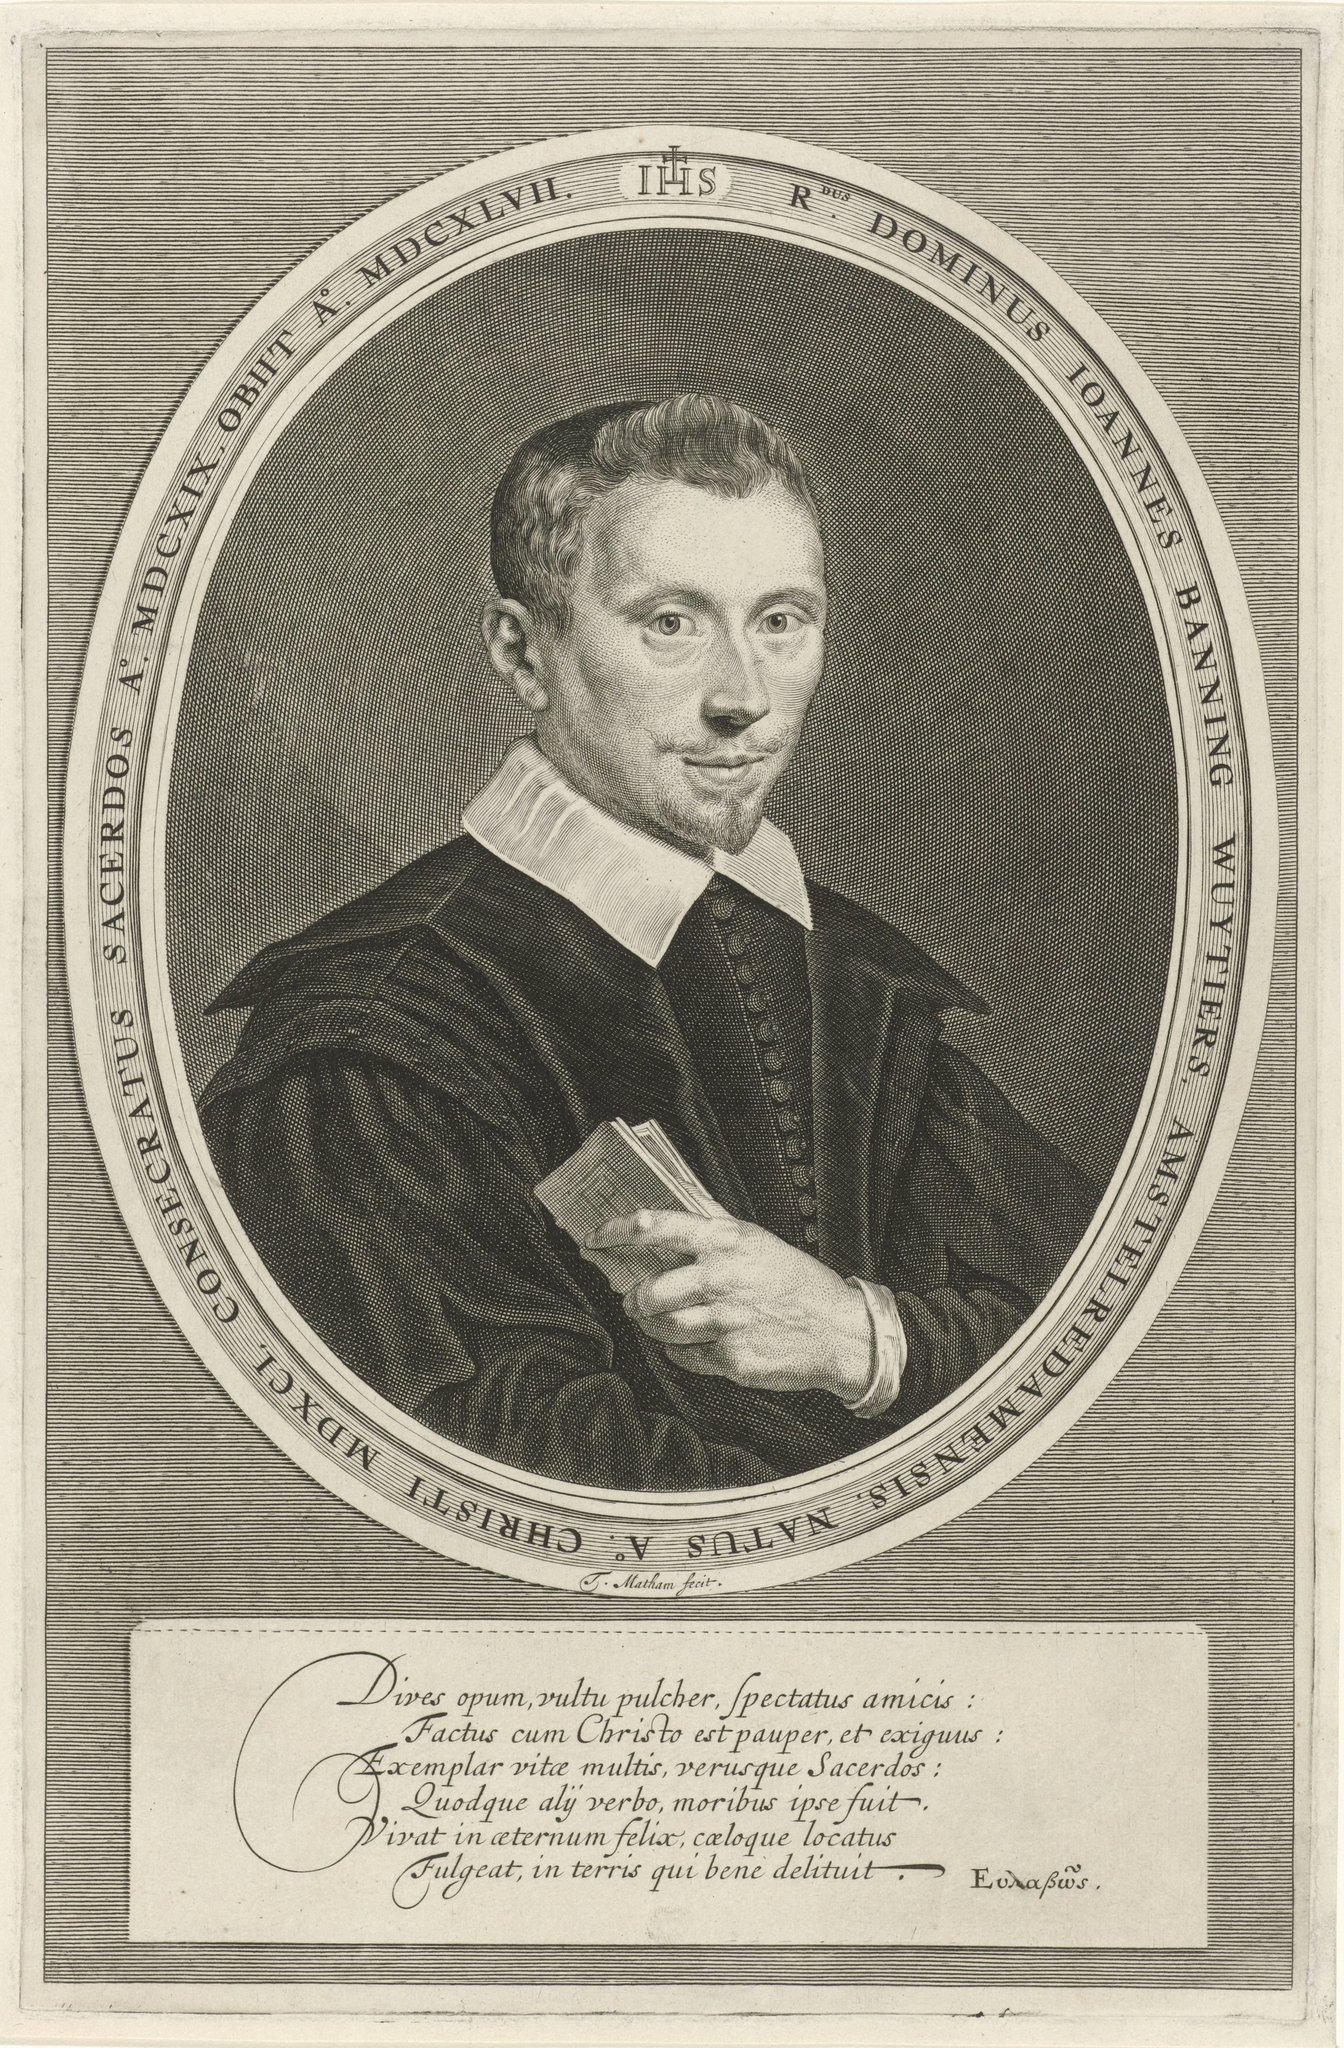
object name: print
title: Portret van Joannes Banning Wuytiers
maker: theodor matham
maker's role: draughtsman, print maker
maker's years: 1605-1676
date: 1647-1676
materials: paper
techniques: engraving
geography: northern netherlands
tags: joannes banning wuytiers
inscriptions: collector's mark: Lugt 2228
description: Portret van Joannes Banning Wuytiers, pastoor te Amsterdam.